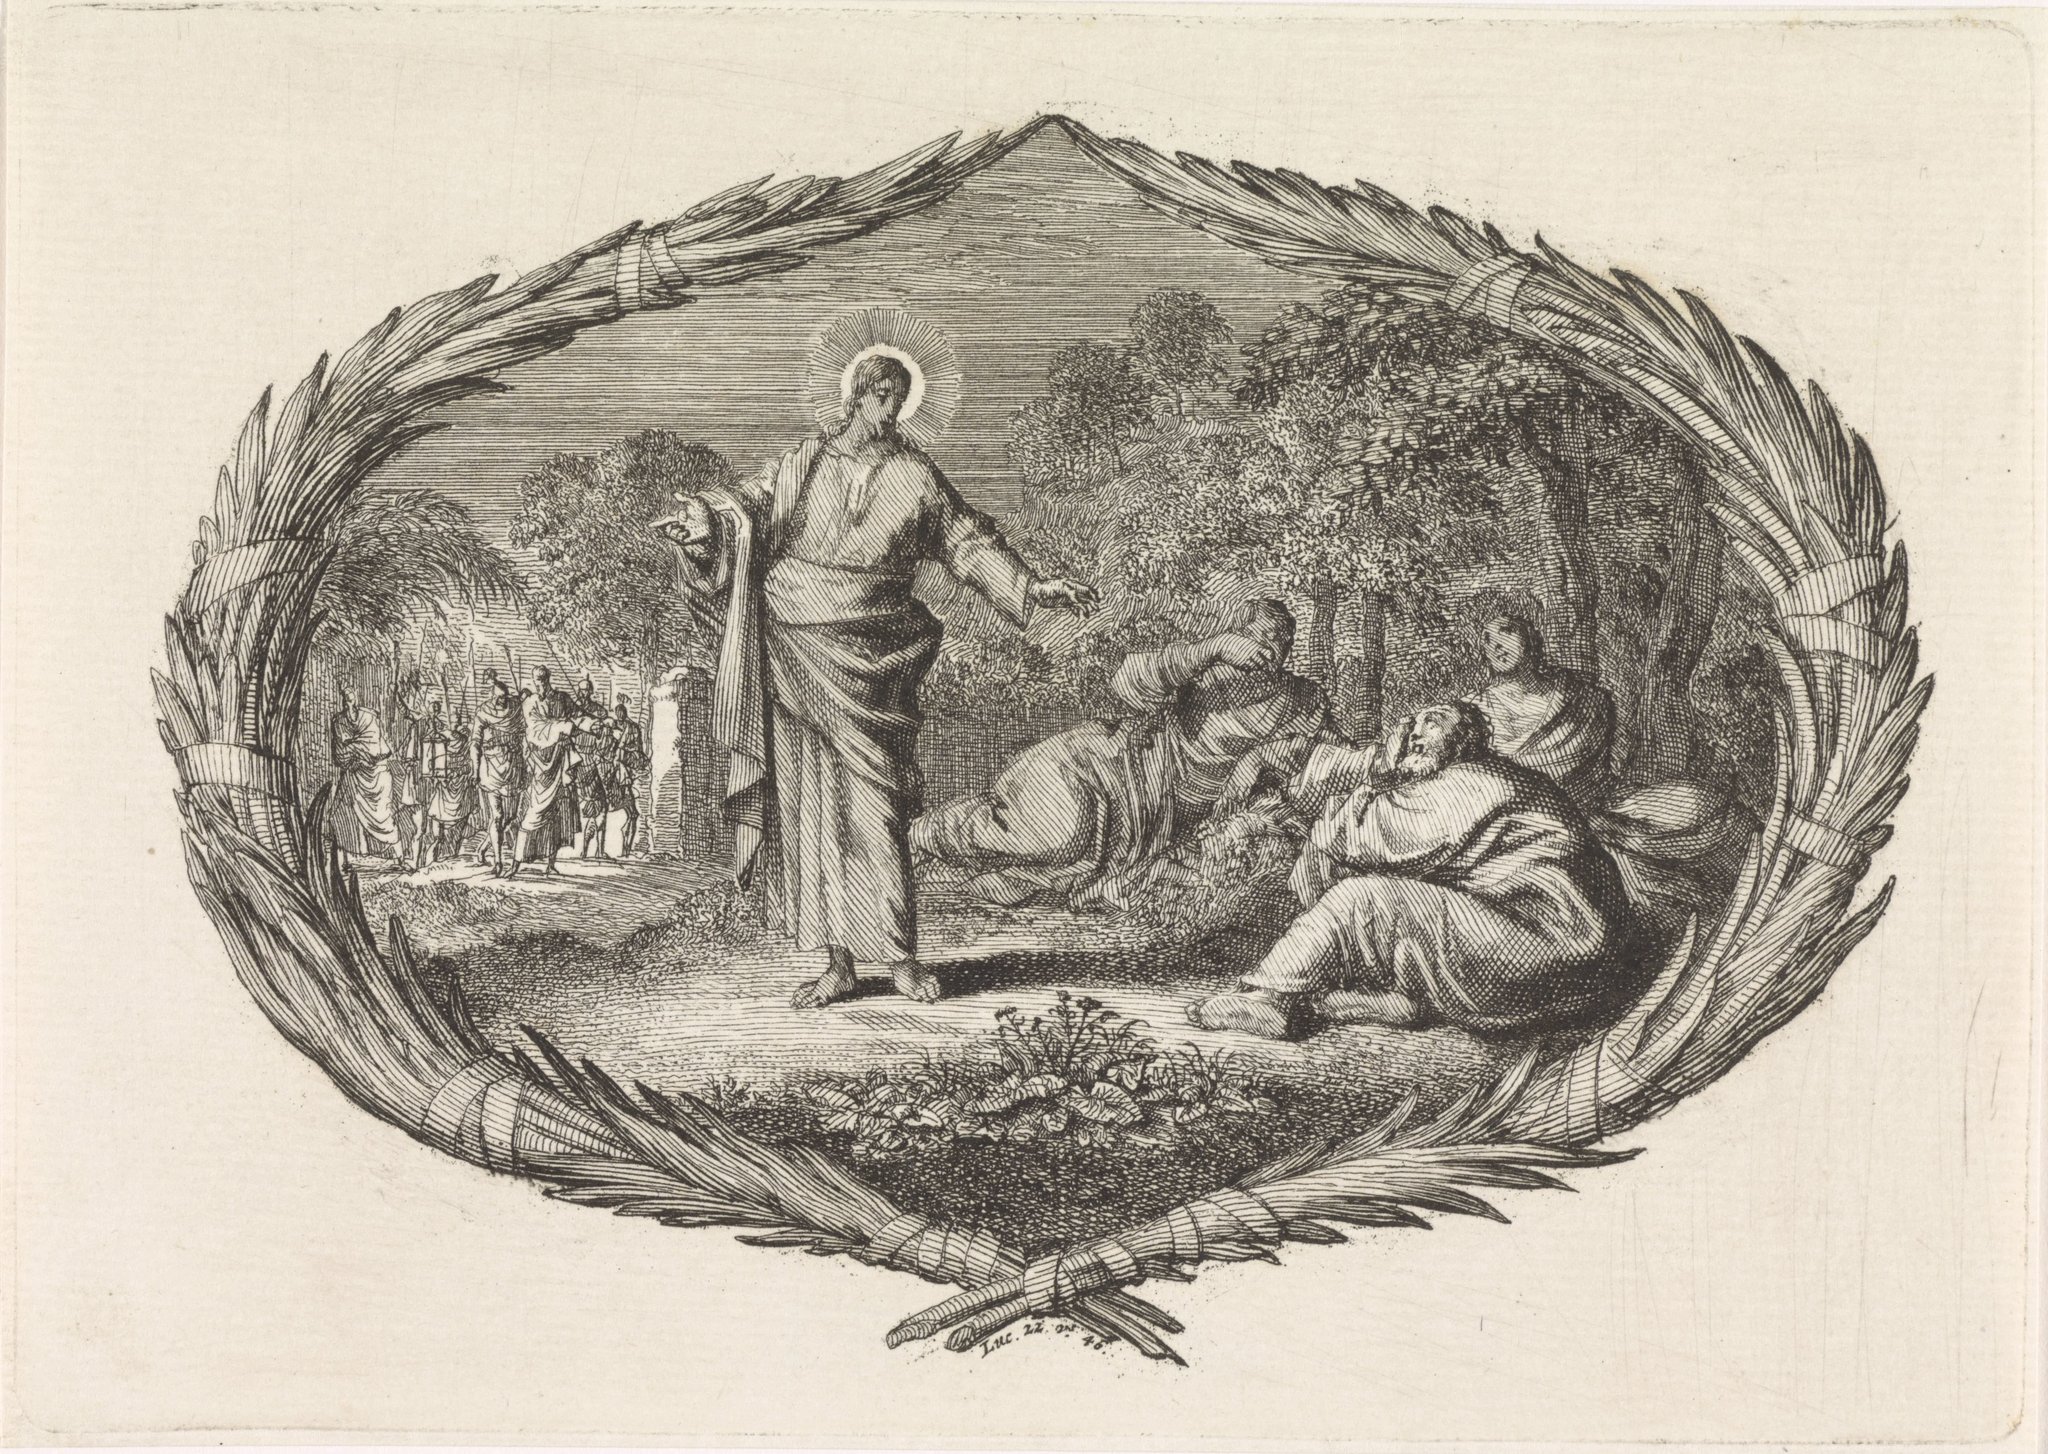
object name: print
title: Christus maakt zijn slapende discipelen wakker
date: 1700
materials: paper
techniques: etching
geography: amsterdam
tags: the kiss of judas: accompanied by soldiers with torches and lanterns, he kisses christ, christ summons the apostles to stay awake and pray ~ garden of gethsemane, ornament ~ cartouche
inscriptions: collector's mark: Lugt 2228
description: Een voorstelling in een cartouche van palmtakken. Christus in de hof van Getsemane. Hij maakt de drie slapende leerlingen wakker. Op de achtergrond verschijnen de soldaten en Judas. Onder de cartouche de Bijbelreferentie Luc. 22:46.